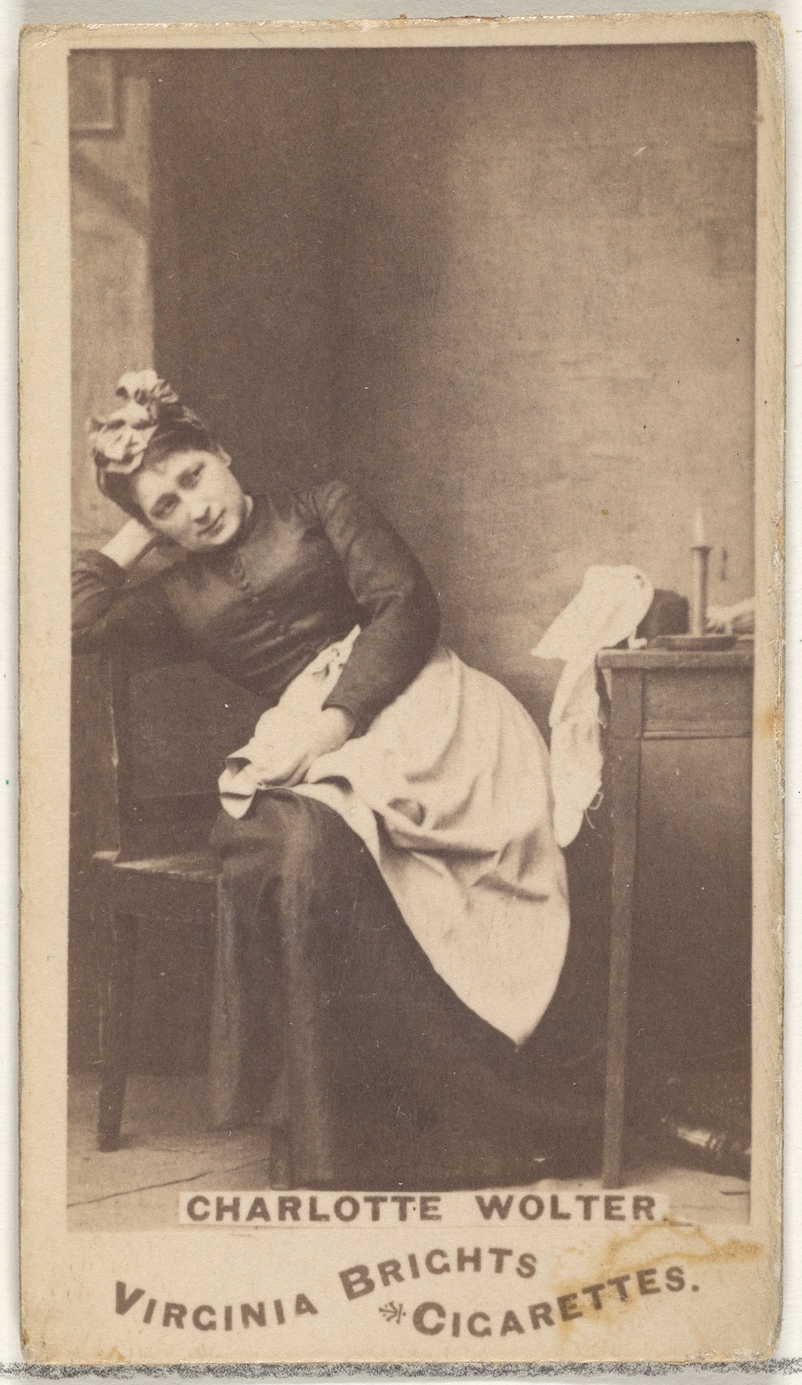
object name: photograph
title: Charlotte Wolter, from the Actors and Actresses series (N45, Type 1) for Virginia Brights Cigarettes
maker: allen & ginter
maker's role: publisher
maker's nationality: american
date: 1888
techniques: albumen silver print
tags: portraits,women,actresses